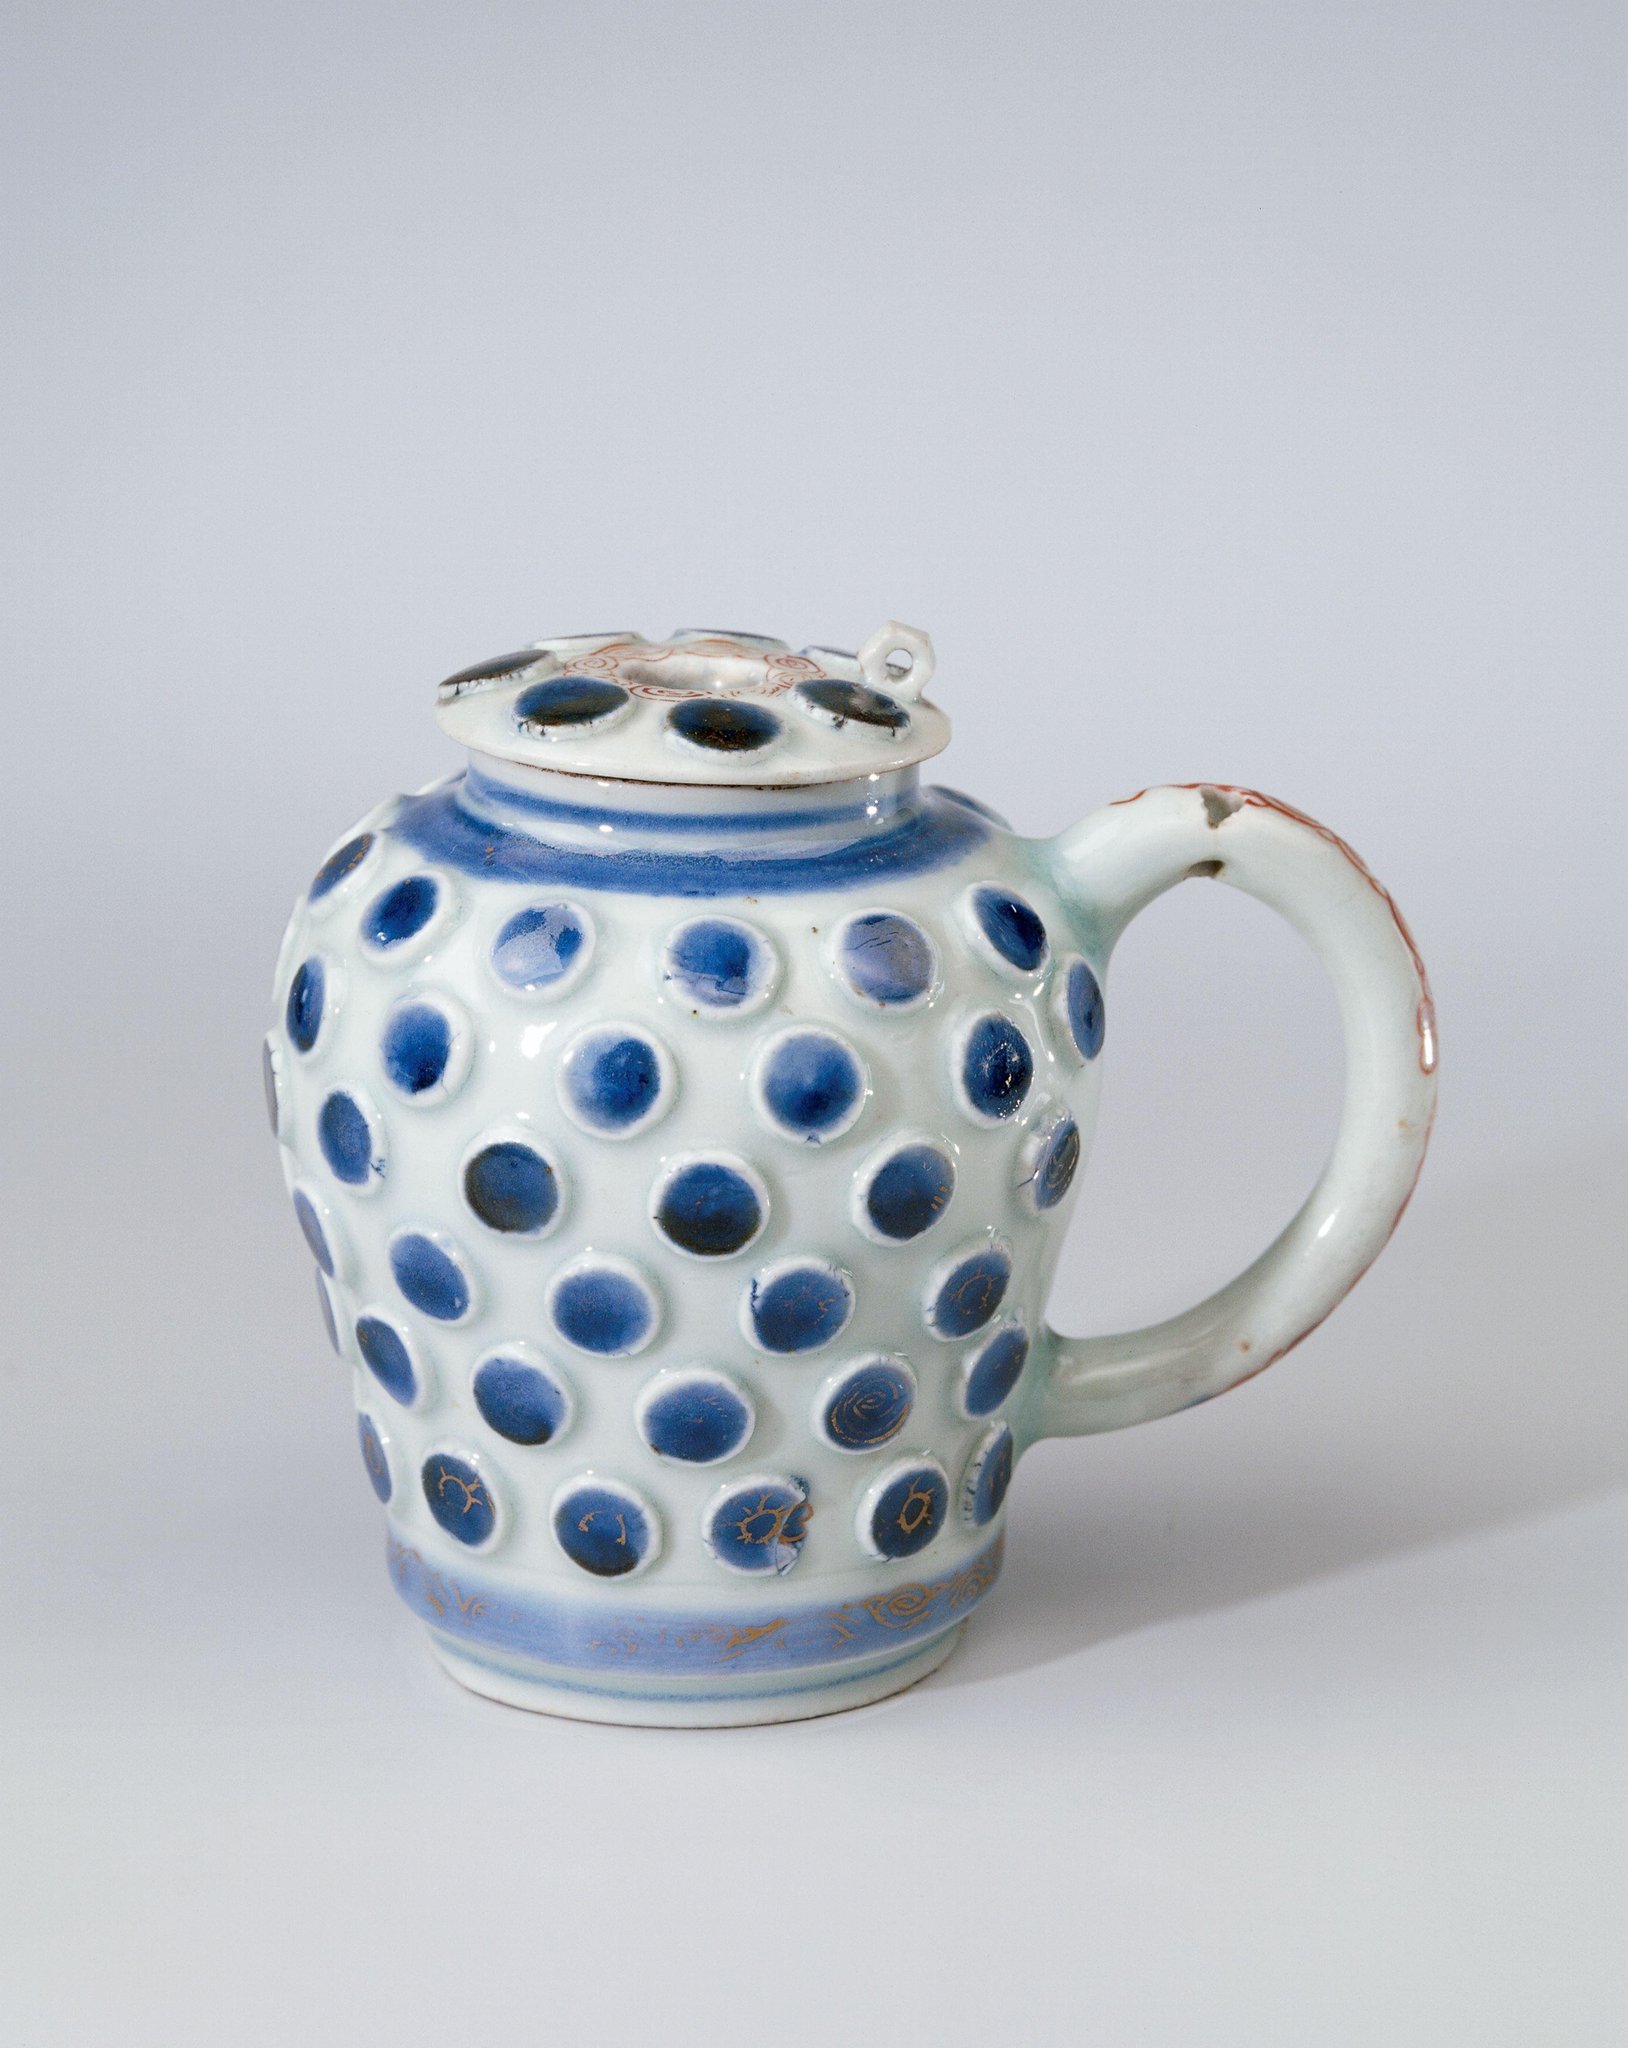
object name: lid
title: Mustard Pot and Beer Jug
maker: Anonymous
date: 1690-1730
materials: cobalt, glaze, gold, paint, porcelain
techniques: firing, gilding, relief, turning, vitrification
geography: japan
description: Deksel van mosyterdpot van porselein, beschilderd in onderglazuur blauw en op het glazuur rood en goud. Bedekt met verhoogde blauwe stippen met een versleten gouddecoratie op elke stip. Om het midden een cirkel met krulwerk. De vorm is in navolging van Duits steengoed. Europese vormen.